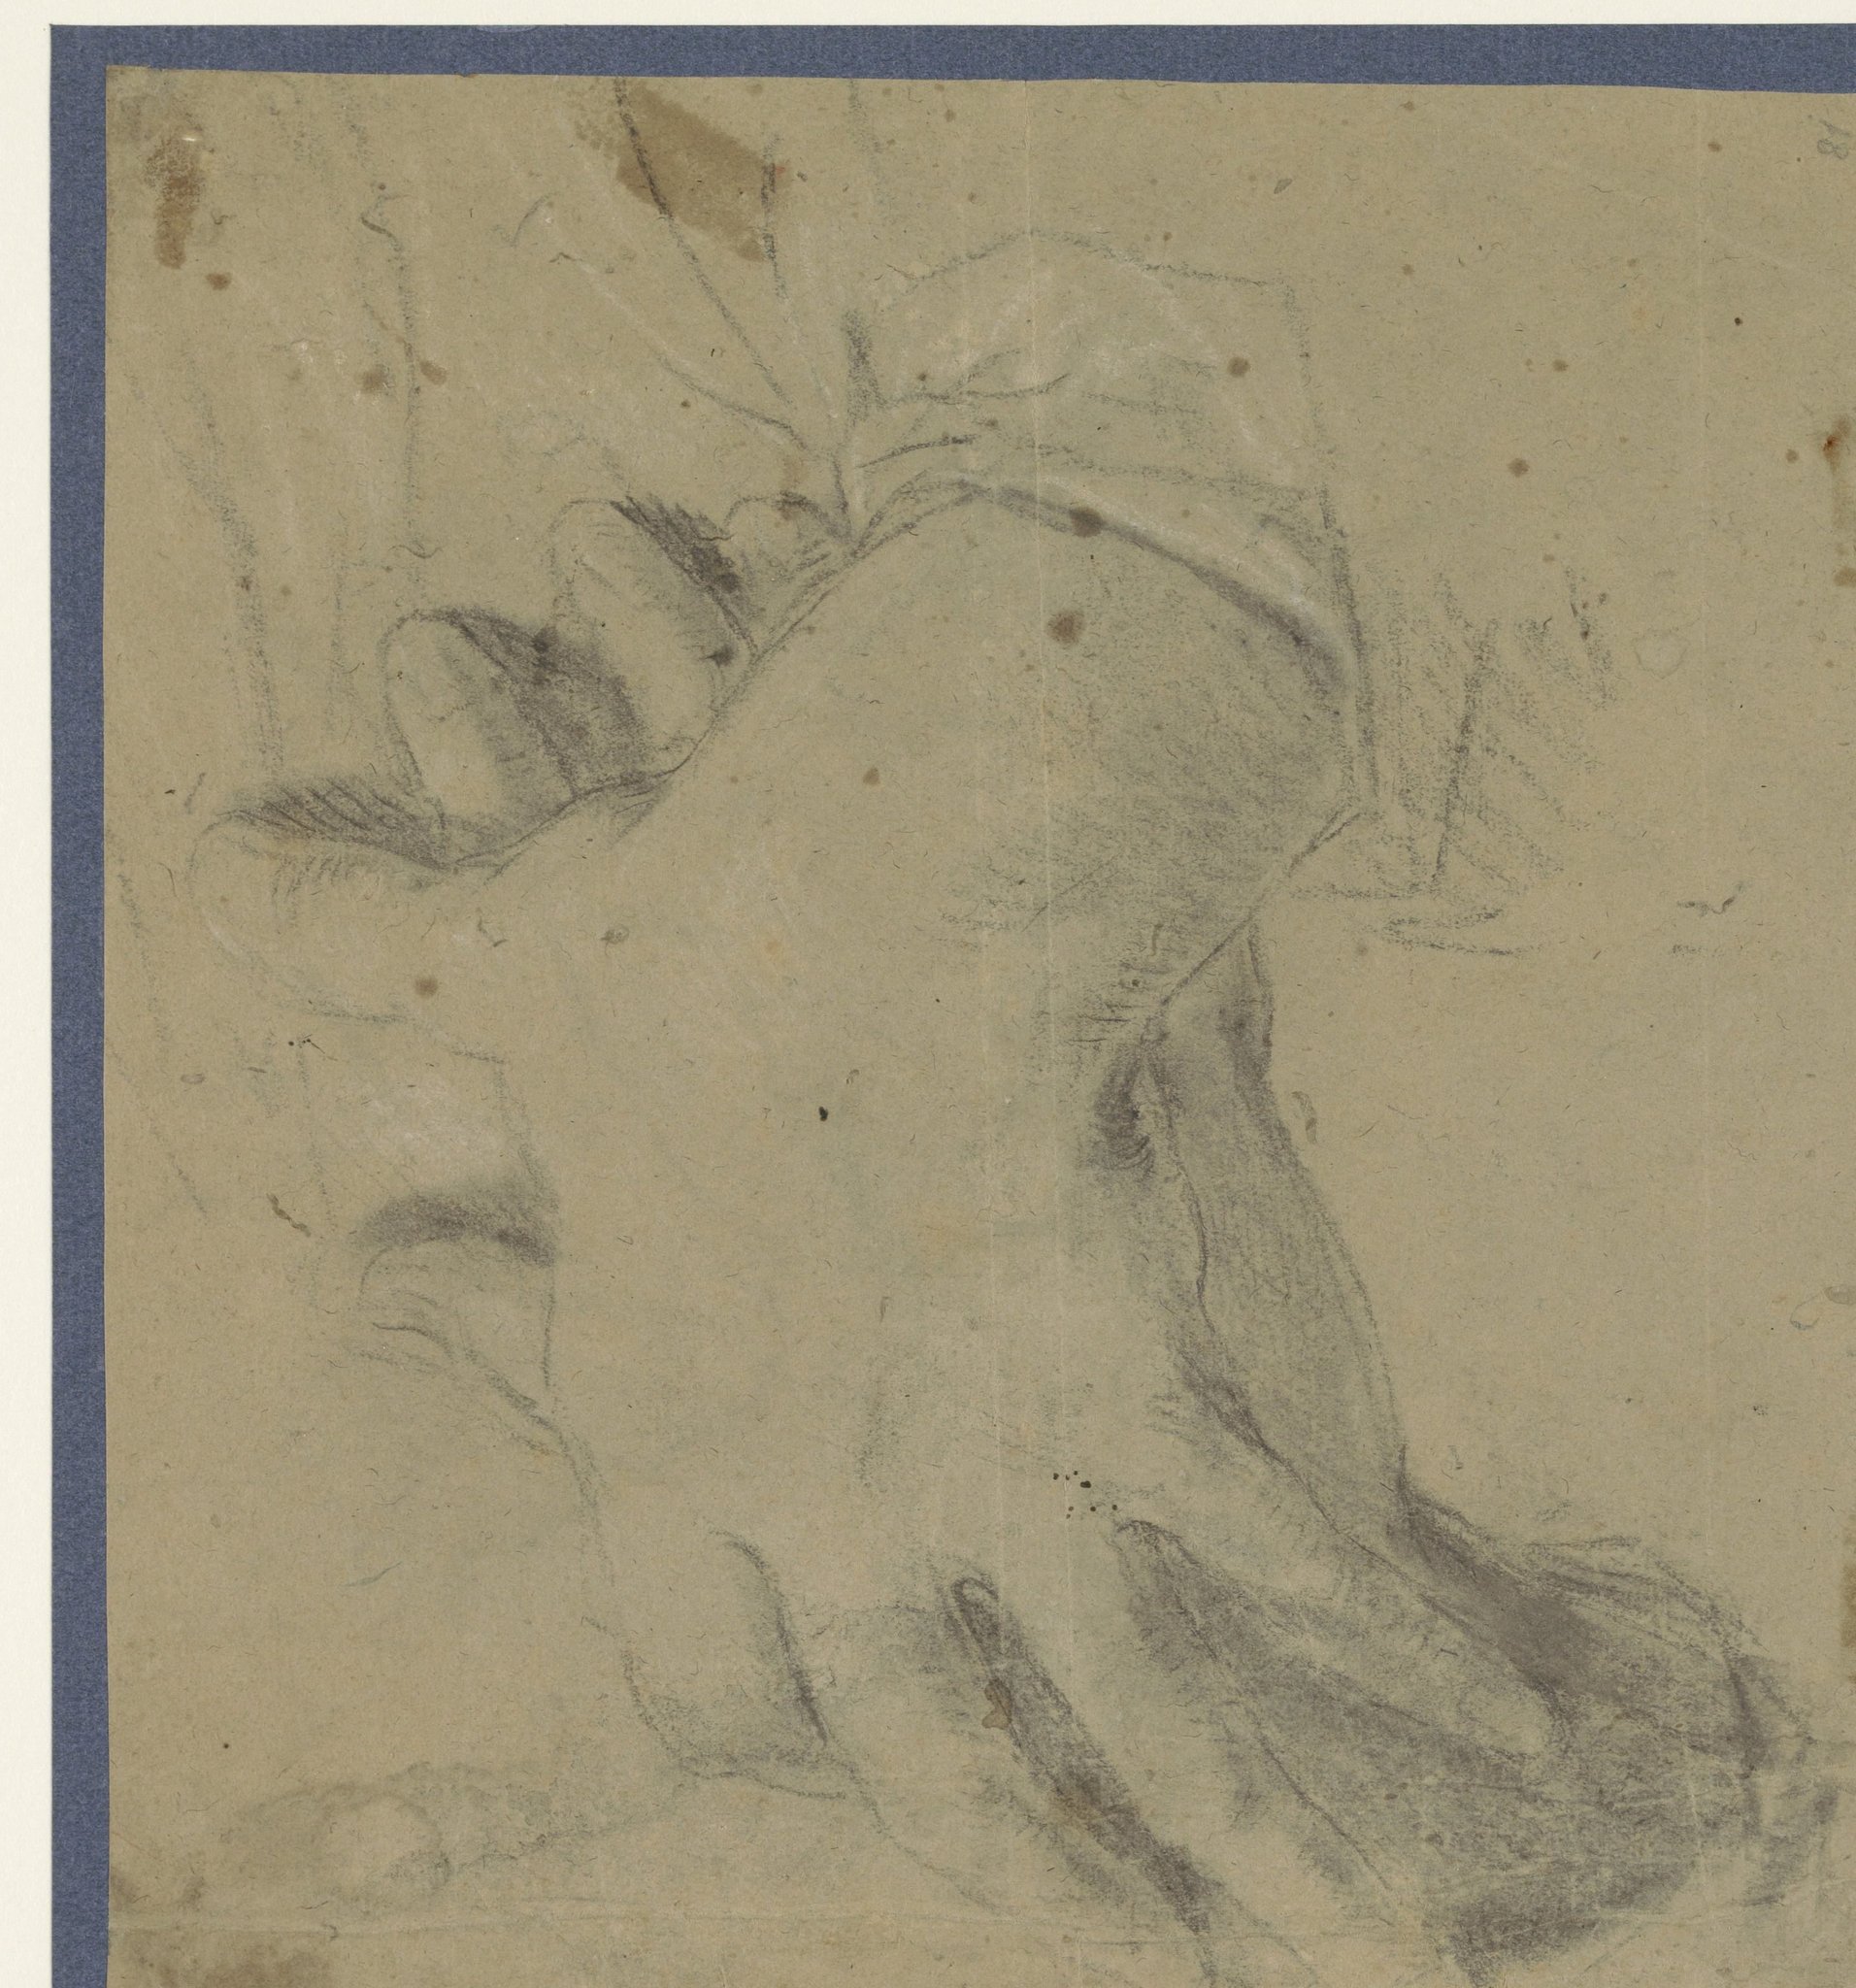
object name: drawing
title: Twee over elkaar gelegde mannenhanden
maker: Anonymous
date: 1650-1670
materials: chalk, charcoal, paper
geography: bologna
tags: postures and gestures of arms and hands